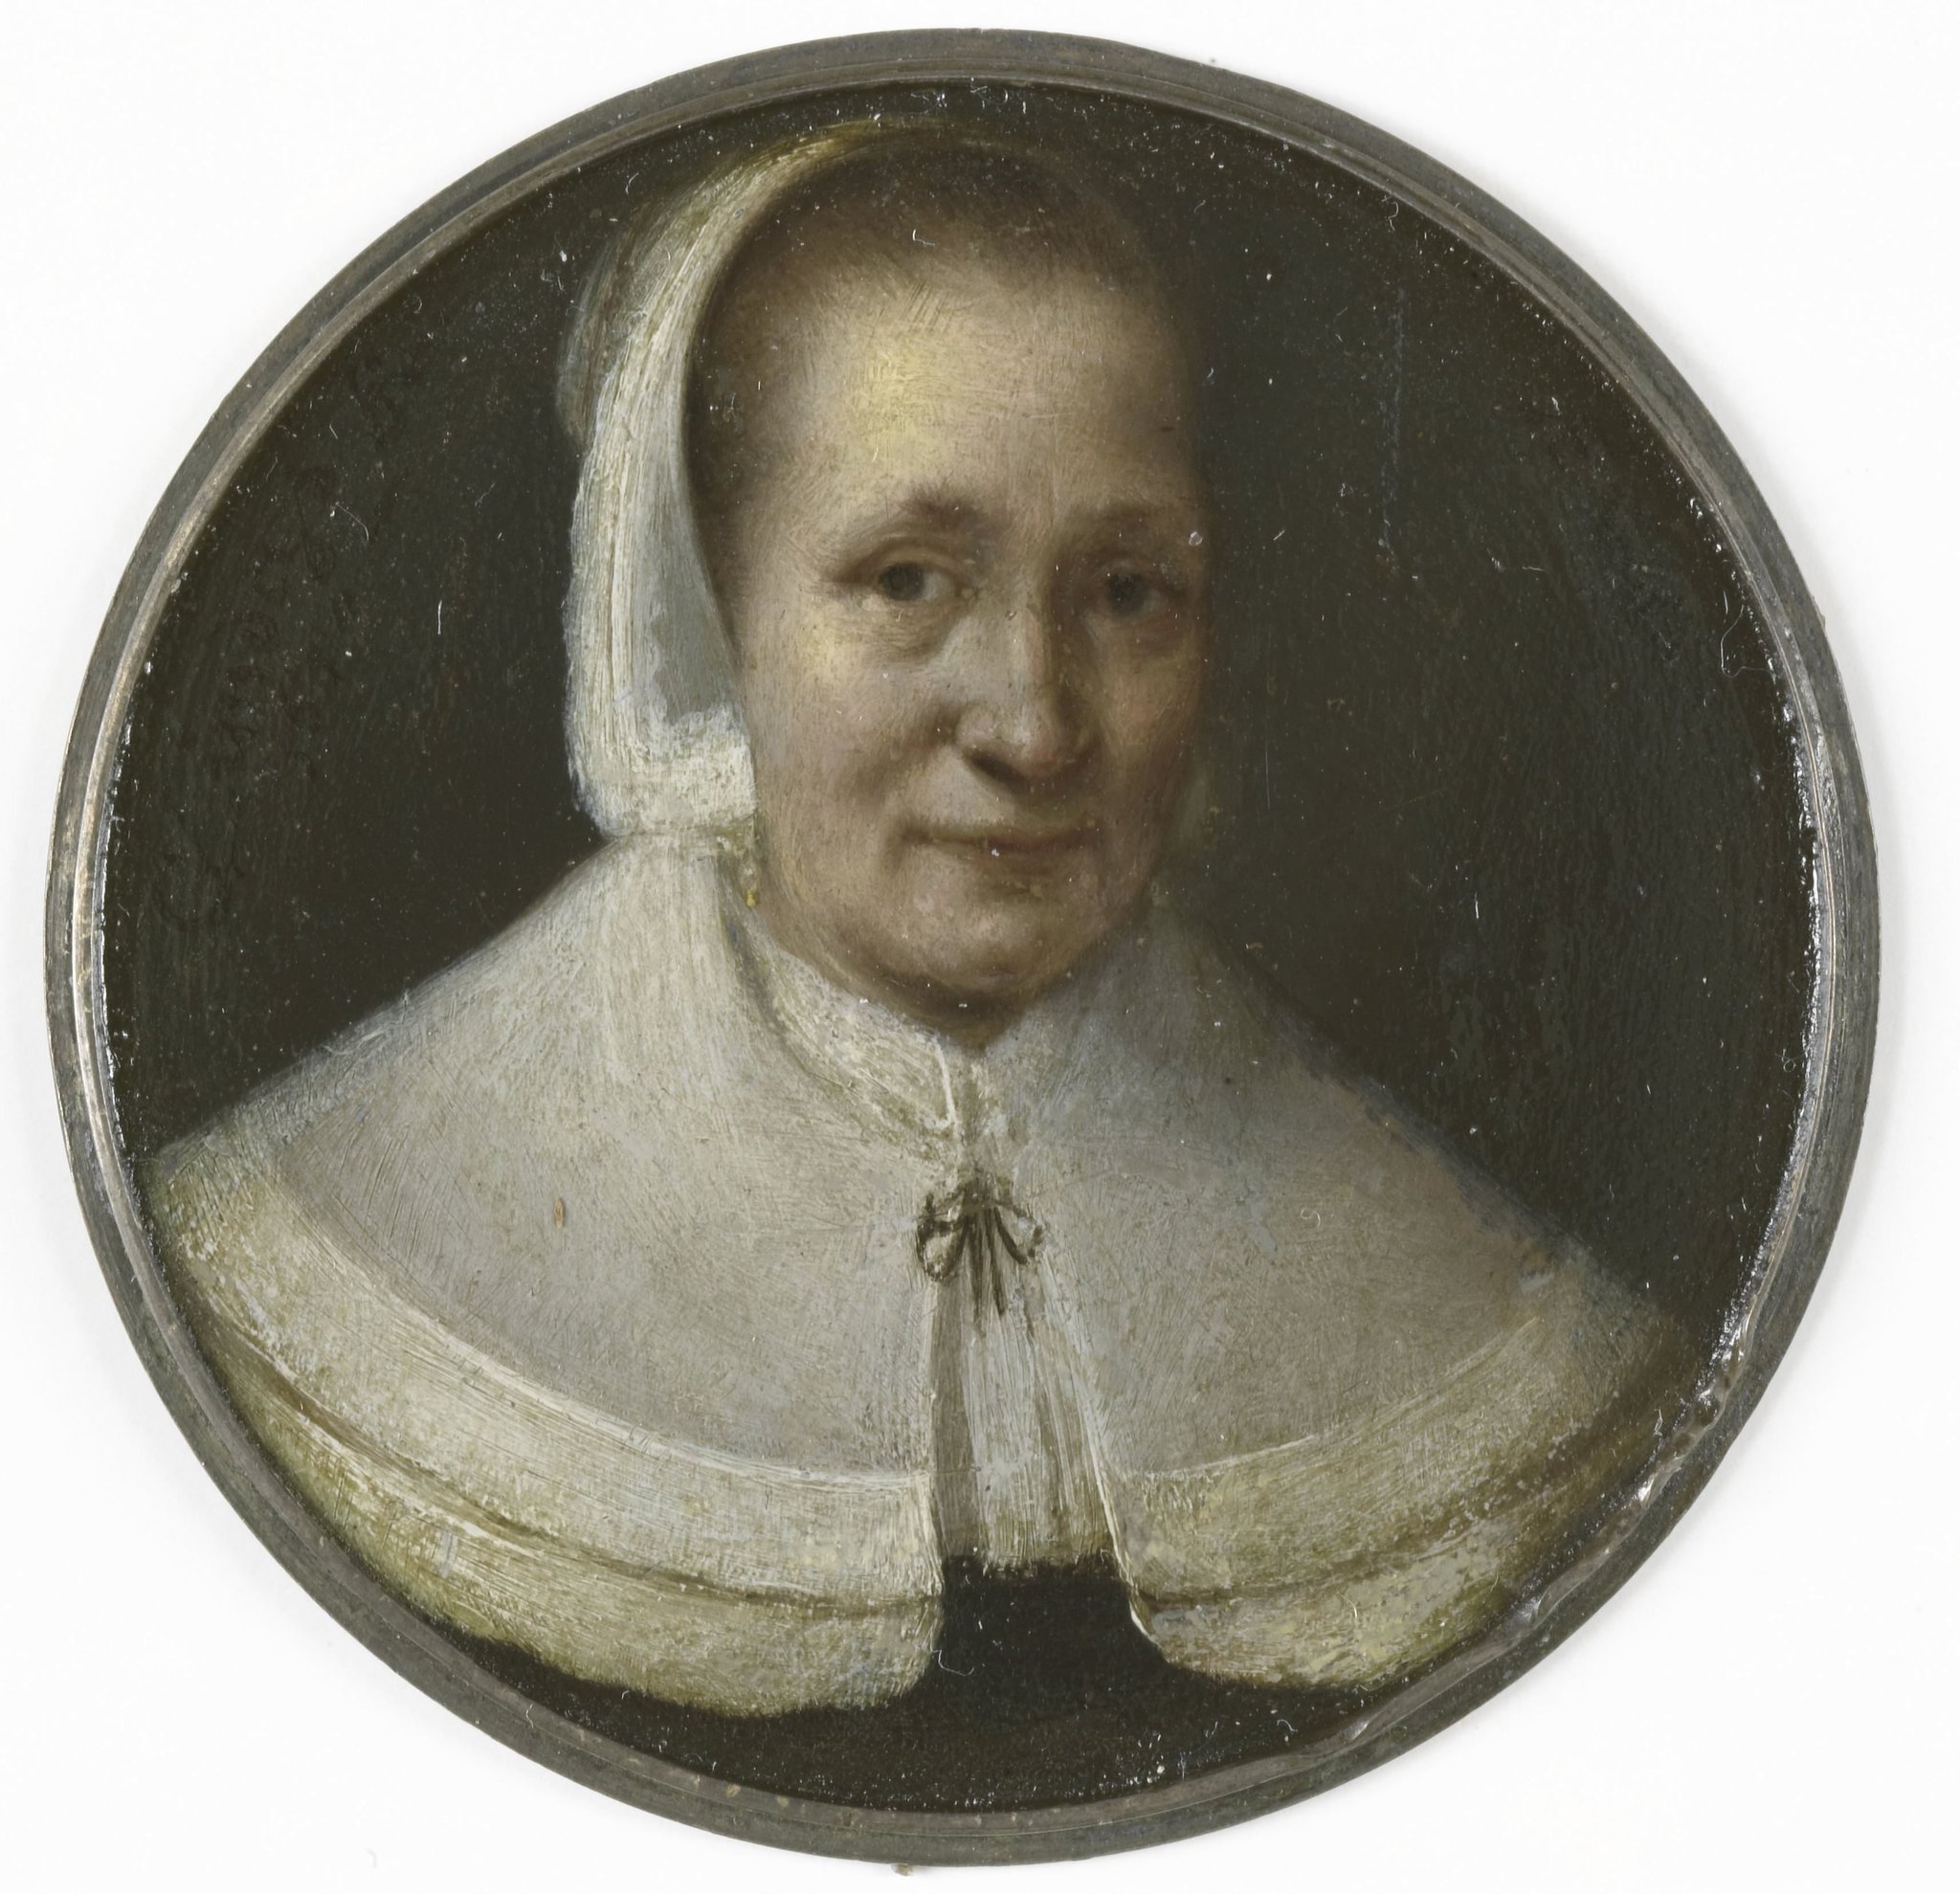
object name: coin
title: Portret van een vijftigjarige vrouw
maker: gerrit lundens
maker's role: painter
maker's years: 1622-1686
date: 1650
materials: oil, silver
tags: historical persons not known by name - bb - woman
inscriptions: signature and date: ‘AE...is 50 / G Lundens ft 1650.’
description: Gerrit Lundens (1622 - after 1683). Portraits of a young man and a woman. Oilpaint on silver, 1650.